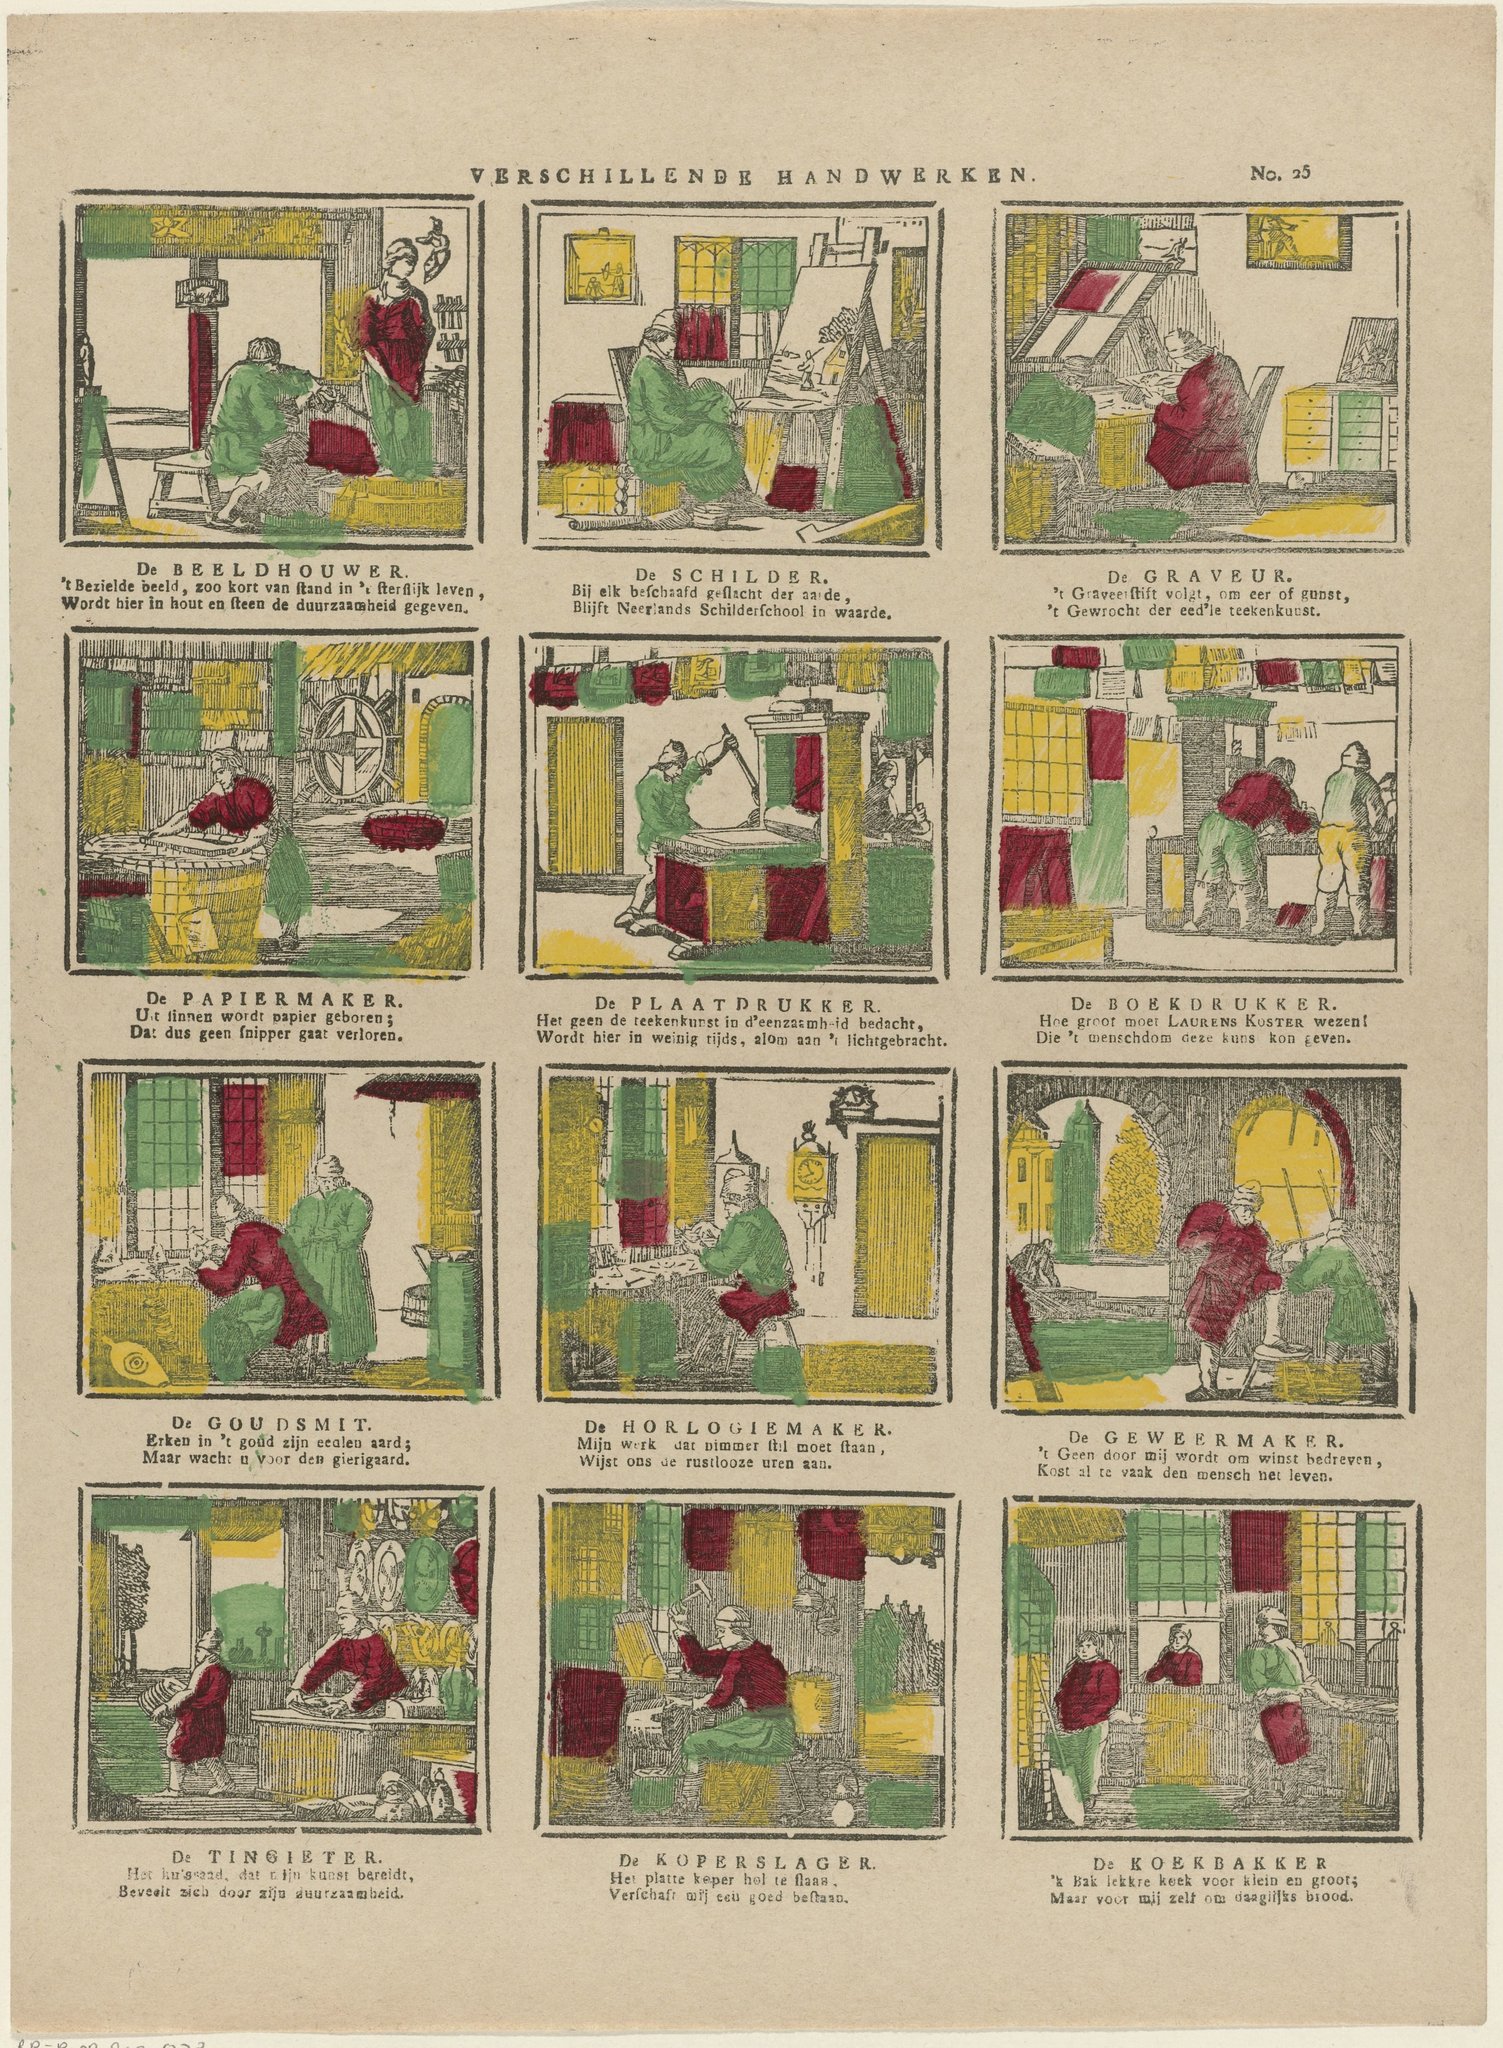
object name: print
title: Verschillende handwerken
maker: Anonymous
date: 1856-1900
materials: paper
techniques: colour, letterpress printing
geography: turnhout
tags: craft-production, skilled handiwork, sculptor at work, printer, crafts and industries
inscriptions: collector's mark: Lugt 2760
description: Blad met 12 voorstellingen van ambachtslieden, zoals beeldhouwer, graveur, horlogemaker en koperslager. Onder elke afbeelding een onderschrift. Genummerd rechtsboven: No. 25.